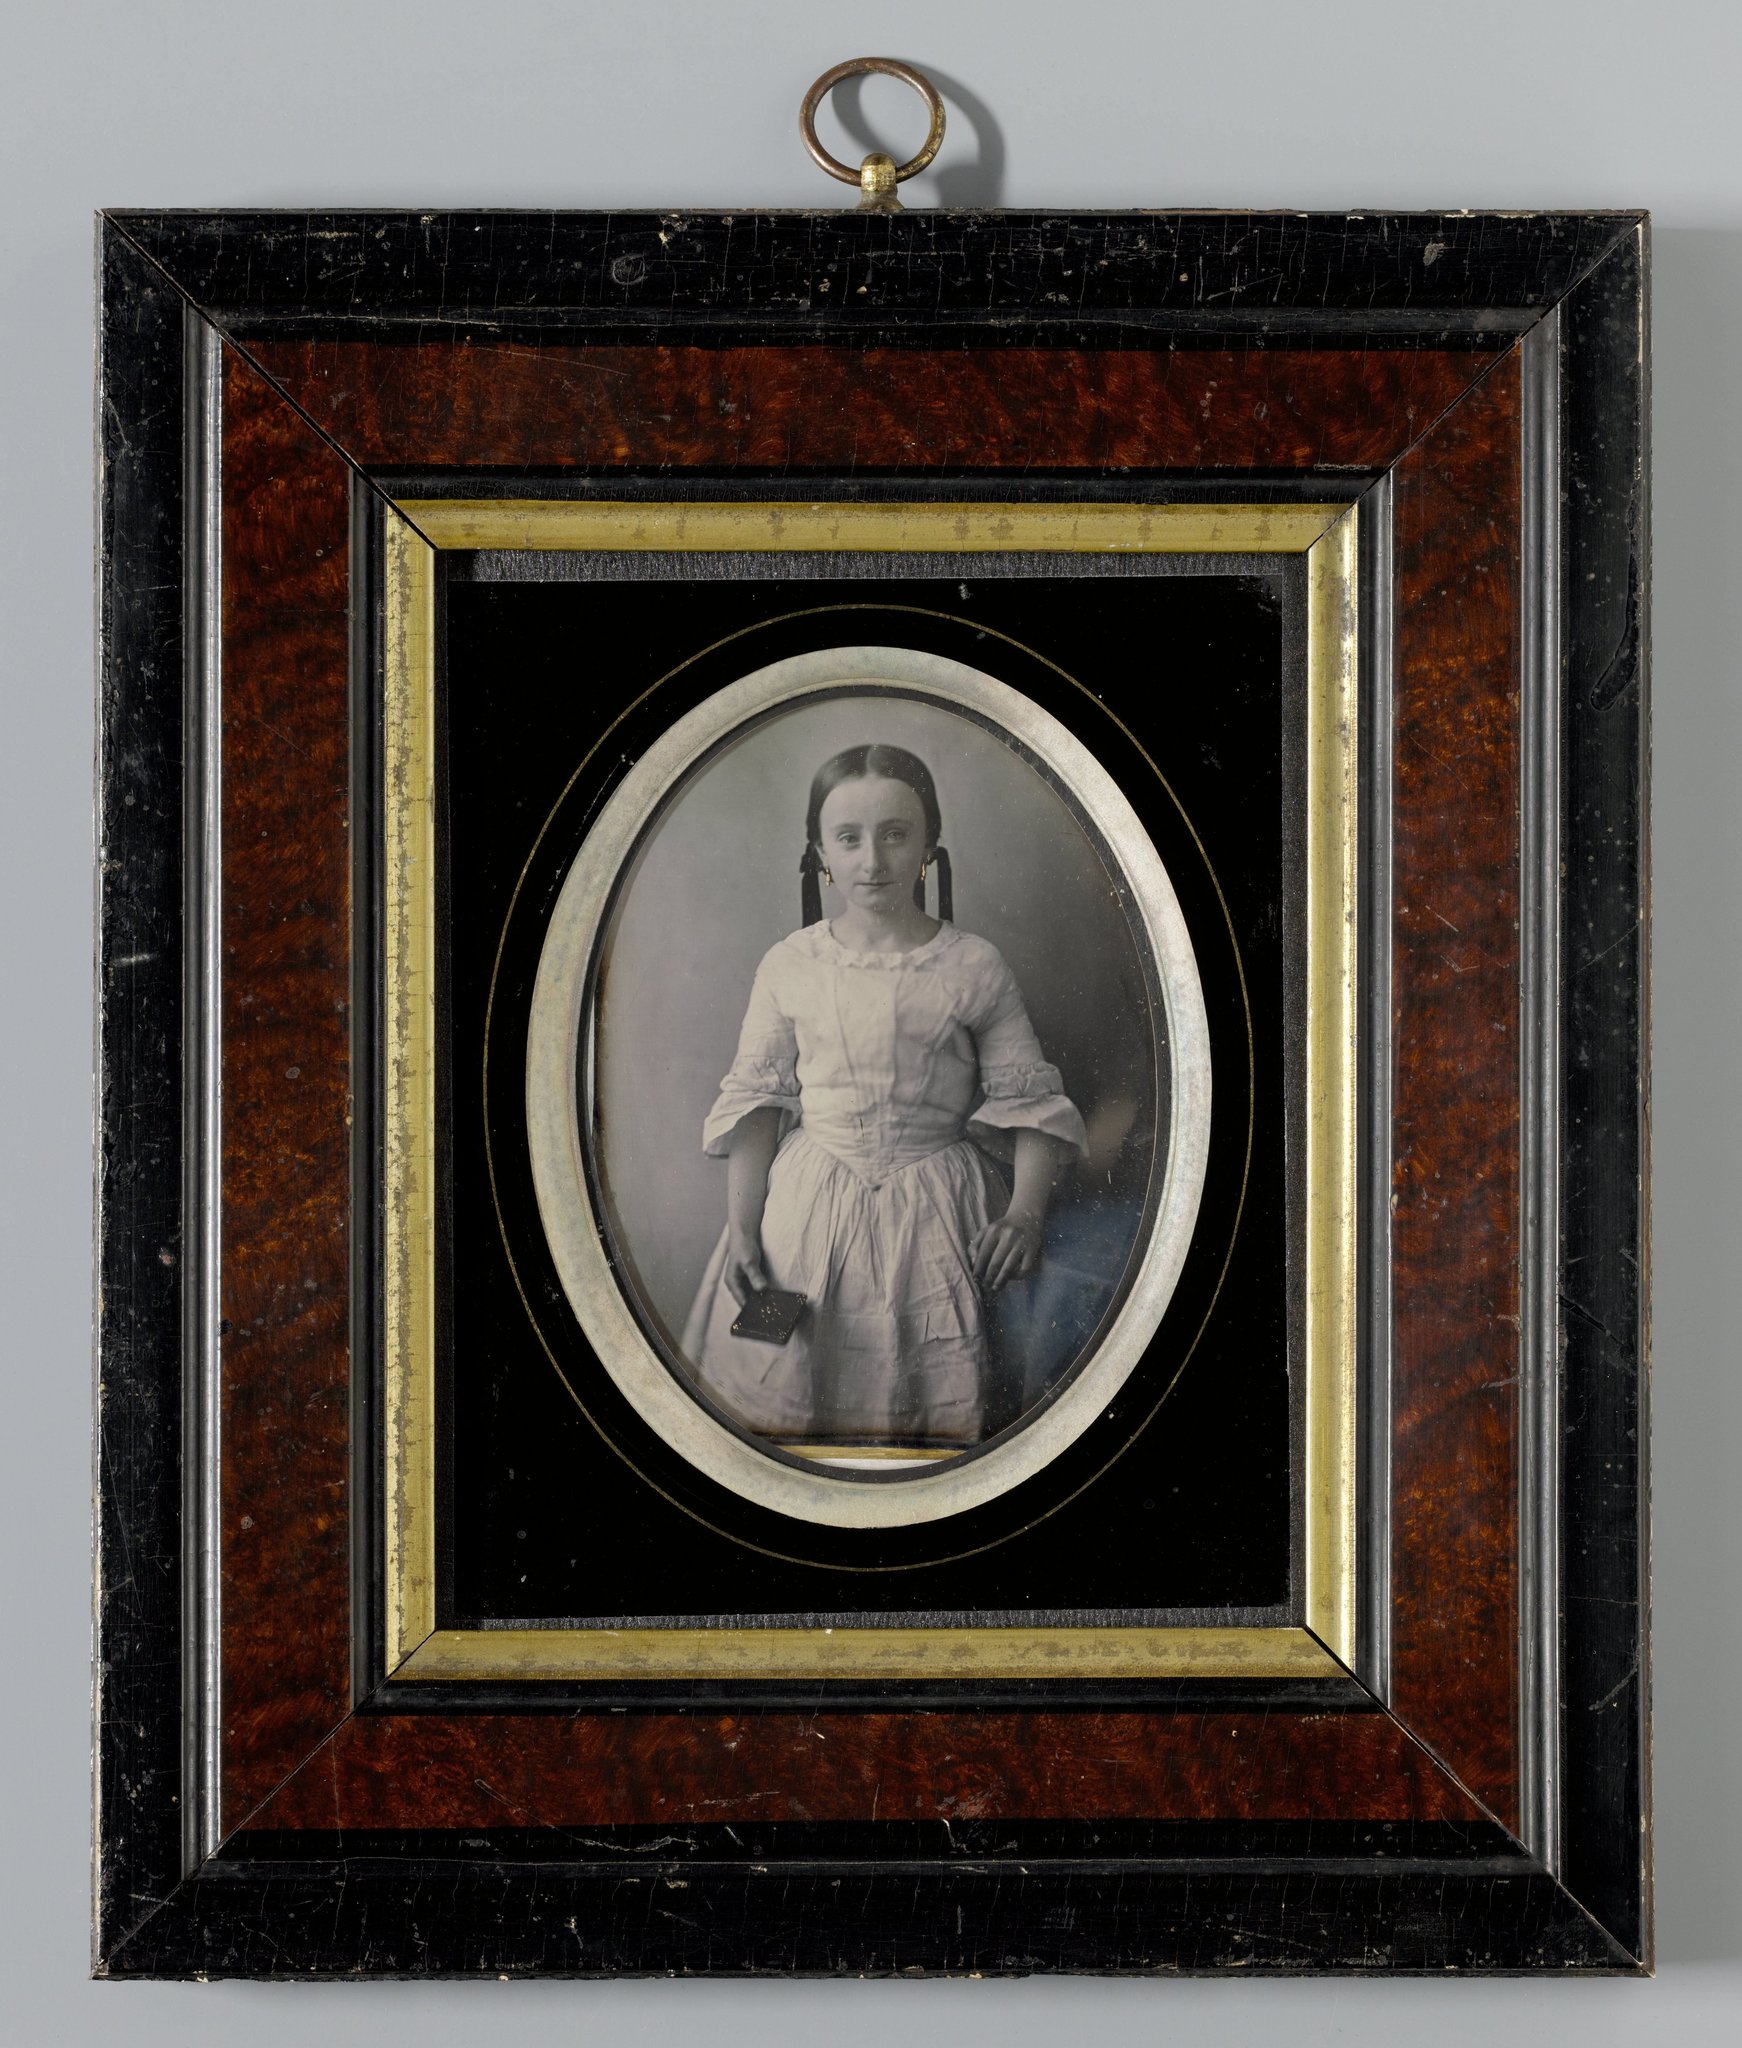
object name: photograph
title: Portrait of Henriëtte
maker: hendrik hermanus roelse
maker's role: fotograaf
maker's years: 1831-1872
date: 1806-1857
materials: copper, glass, photographic support, silver, wood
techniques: daguerreotype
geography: middelburg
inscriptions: label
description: Roelse practiced the curious occupation of daguerreotypist in Middelburg, in the Province of Zeeland. He did so in the (scanty) hours of daylight in the Netherlands. Ten-year-old Henriëtte smiles faintly at the man behind the camera. Later her earrings were coloured in with gold paint and the studio’s tablecloth prop with blue paint.